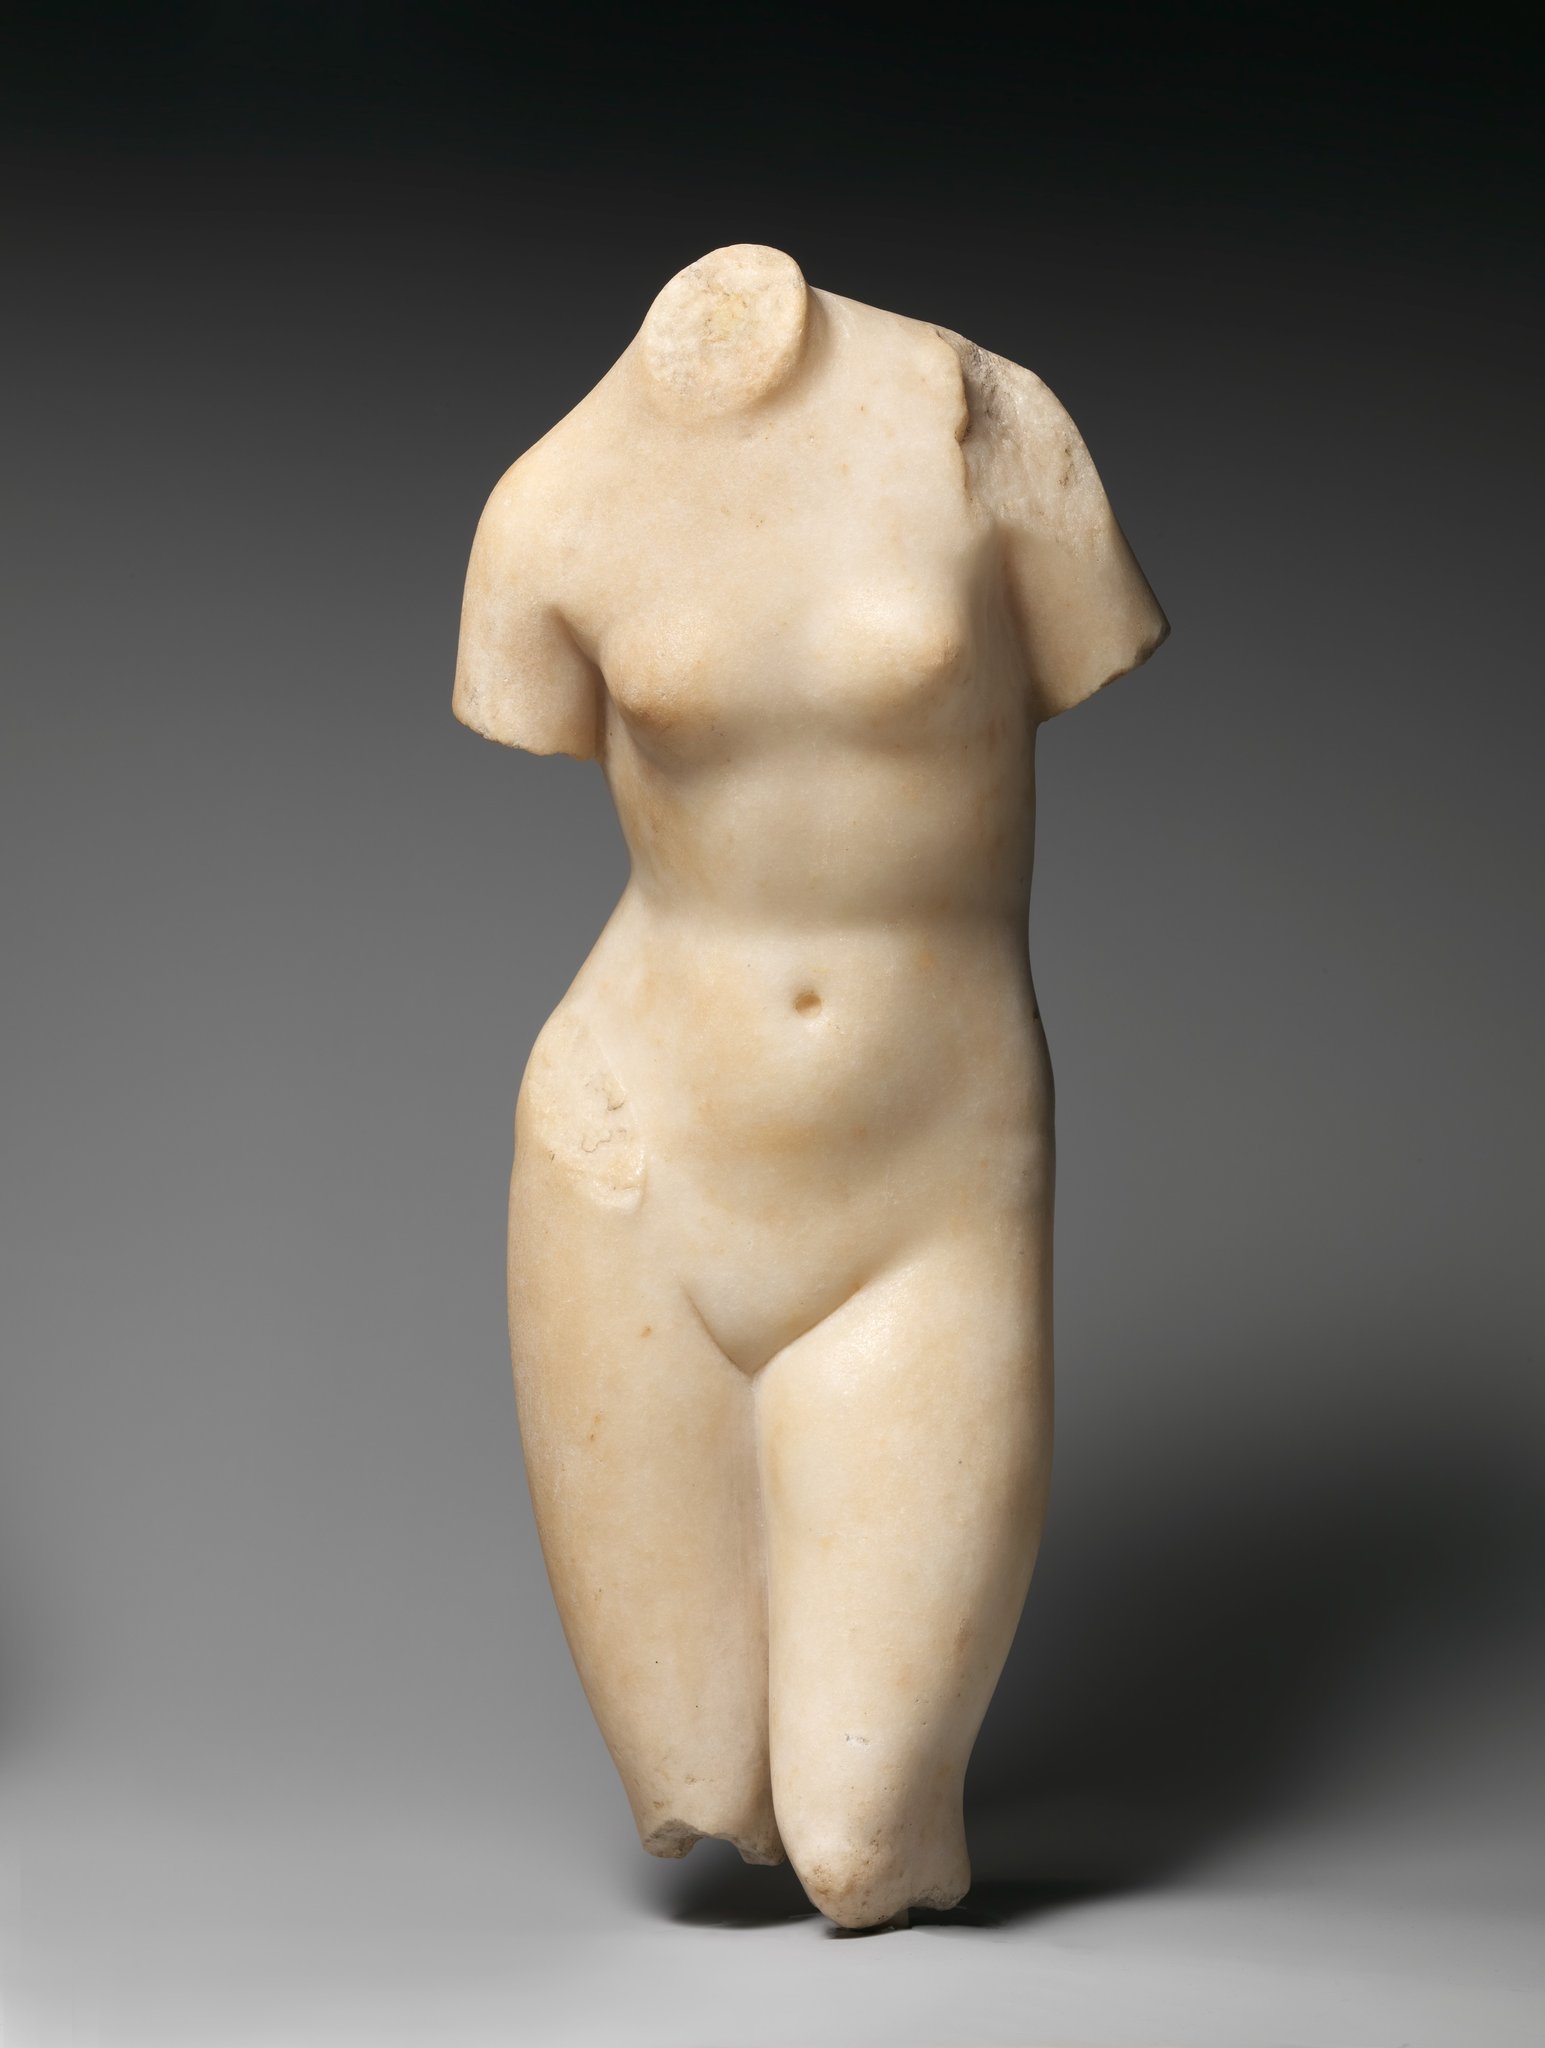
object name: statuette of aphrodite, knidian type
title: Marble statuette of Aphrodite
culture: roman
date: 1-200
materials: marble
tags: aphrodite